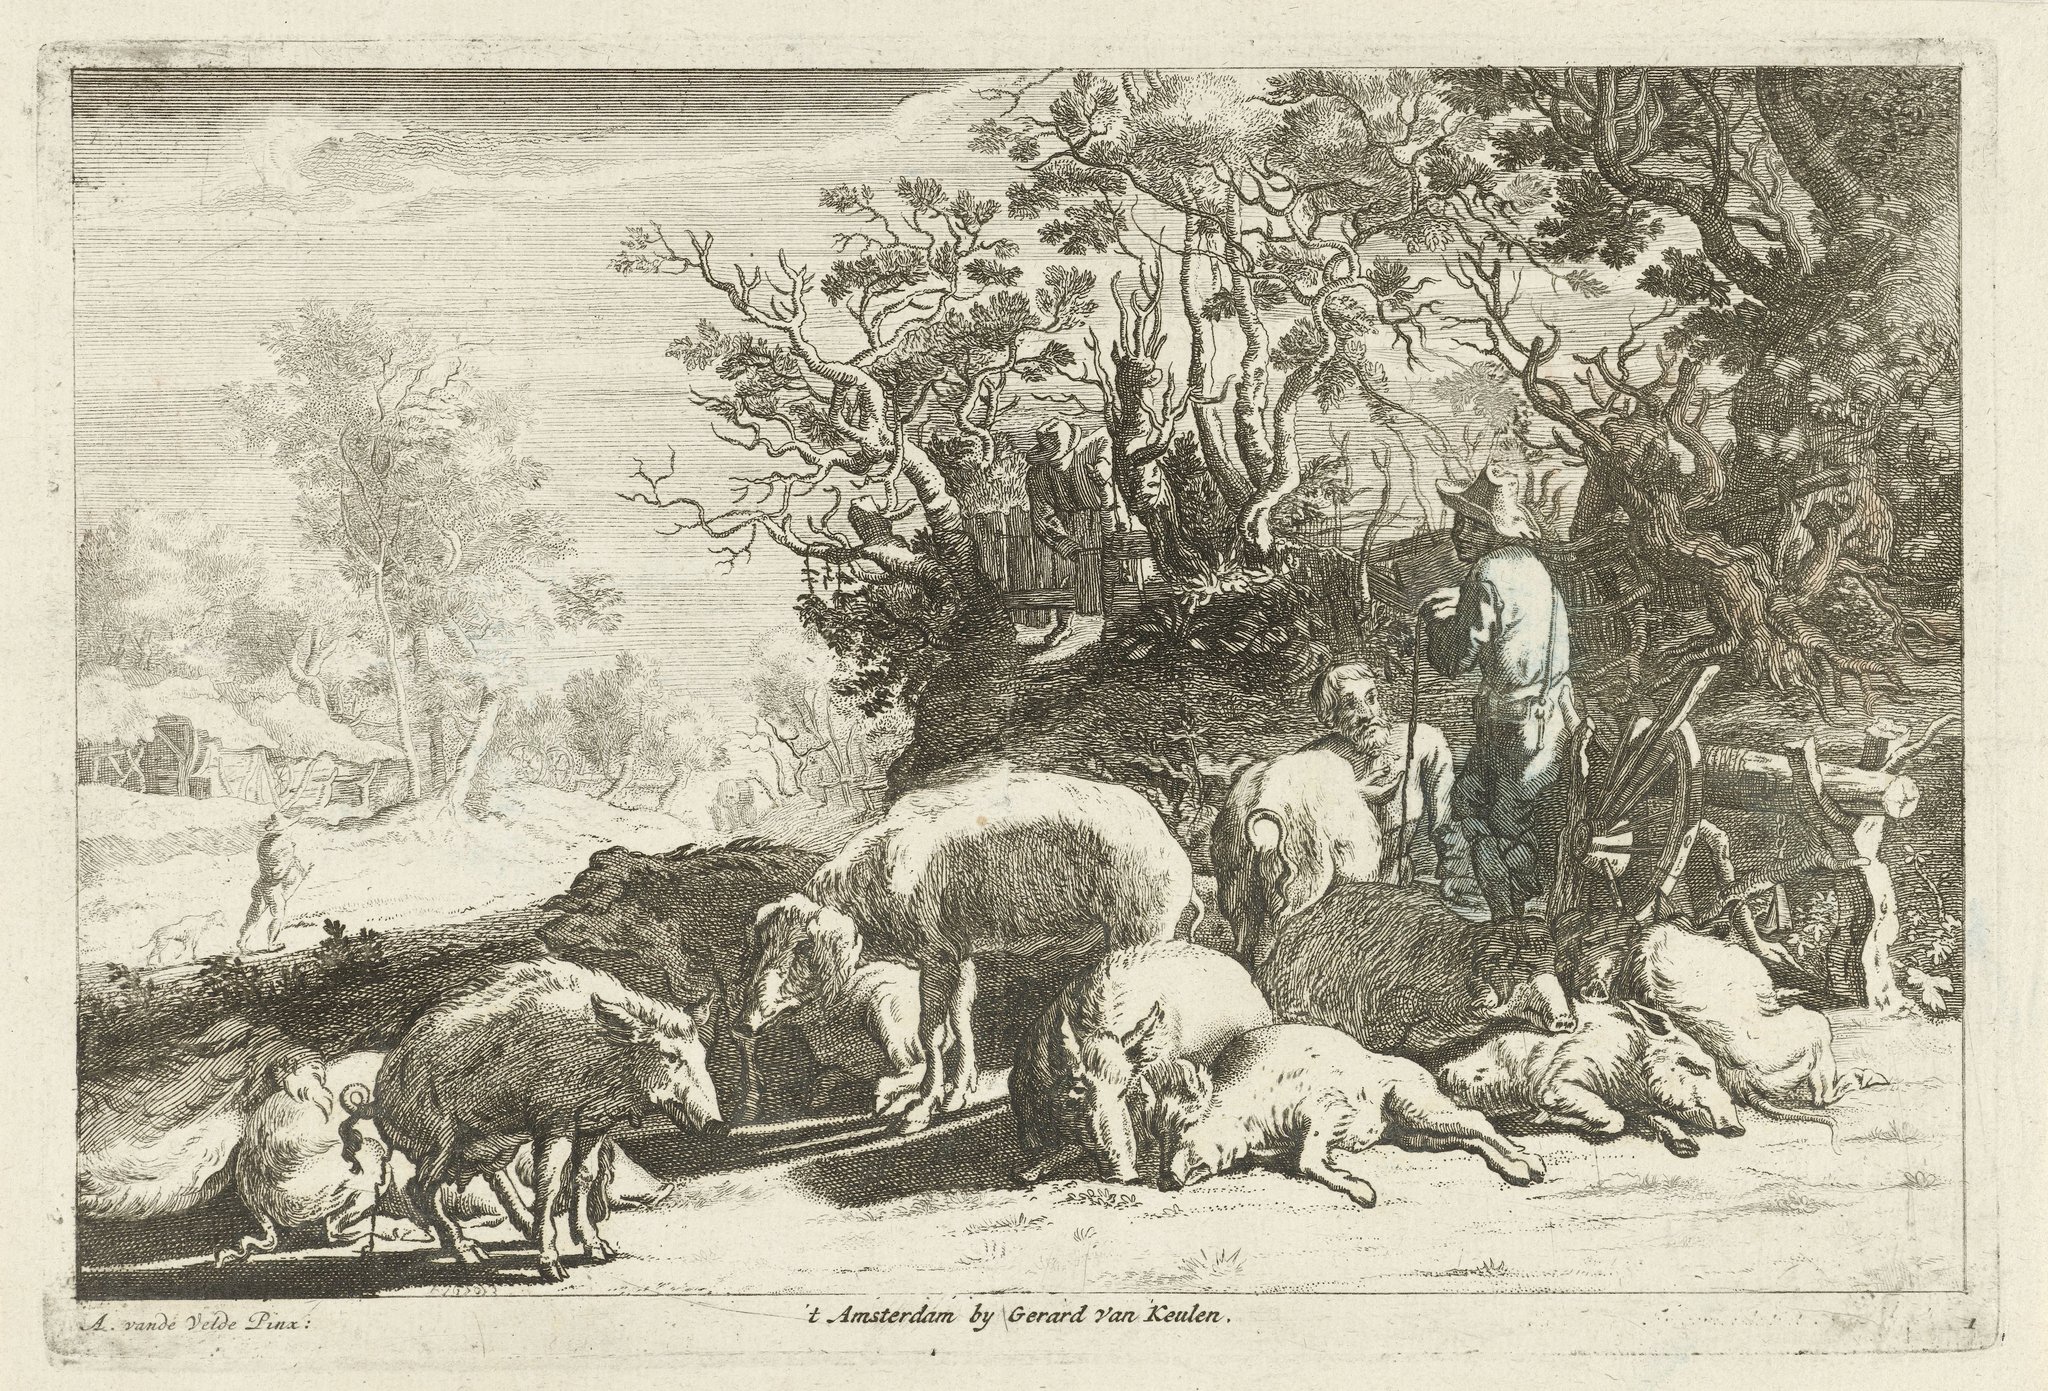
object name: print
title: Varkenshoeder met kudde varkens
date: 1670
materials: paper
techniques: engraving, etching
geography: amsterdam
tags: pig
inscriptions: collector's mark: Lugt 2228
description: Boslandschap met kudde varkens en een varkenshoeder. Links op de voorgrond een poepend varken. Op de achtergrond op een heuvel, tussen de bomen, een omheining met een man bij een hek. Rechtsonder: 1.